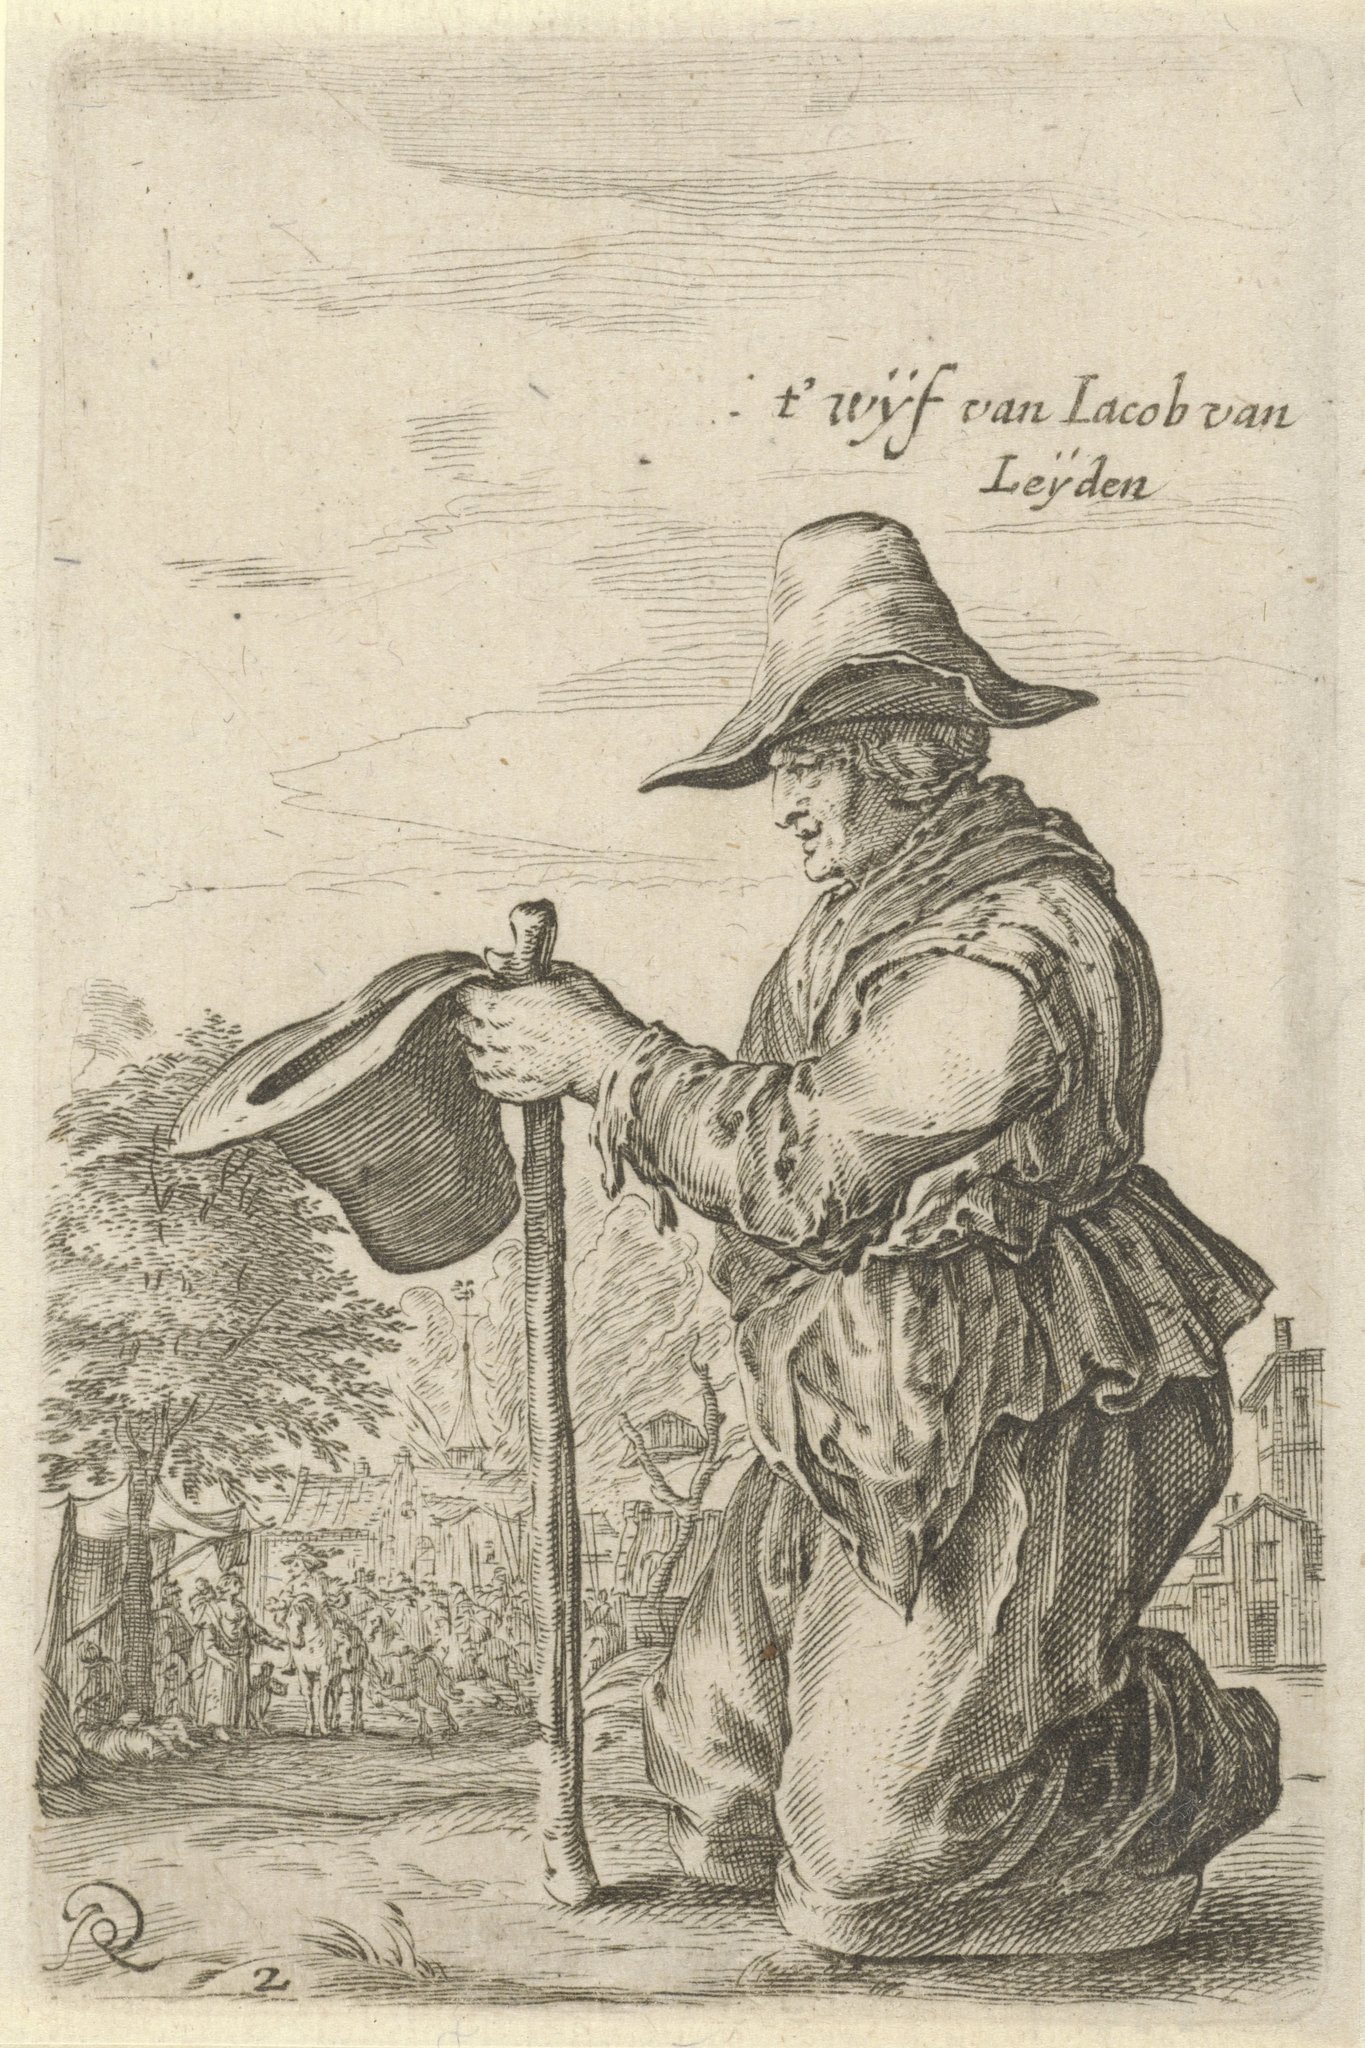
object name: cartoon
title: Bedelaars en boeren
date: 1638-1665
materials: paper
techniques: engraving, etching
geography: amsterdam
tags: beggar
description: Bedelende vrouw zonder voeten, met stok en hoed in de handen. Op de achtergrond soldaten bij een brandend dorp. De prent maakt deel uit van een tiendelige serie met voorstellingen van bedelaars en boeren waarin ook verschillende ongelukkige figuren uit de Eerste Engelse Oorlog zijn opgenomen, ca. 1652-1654.